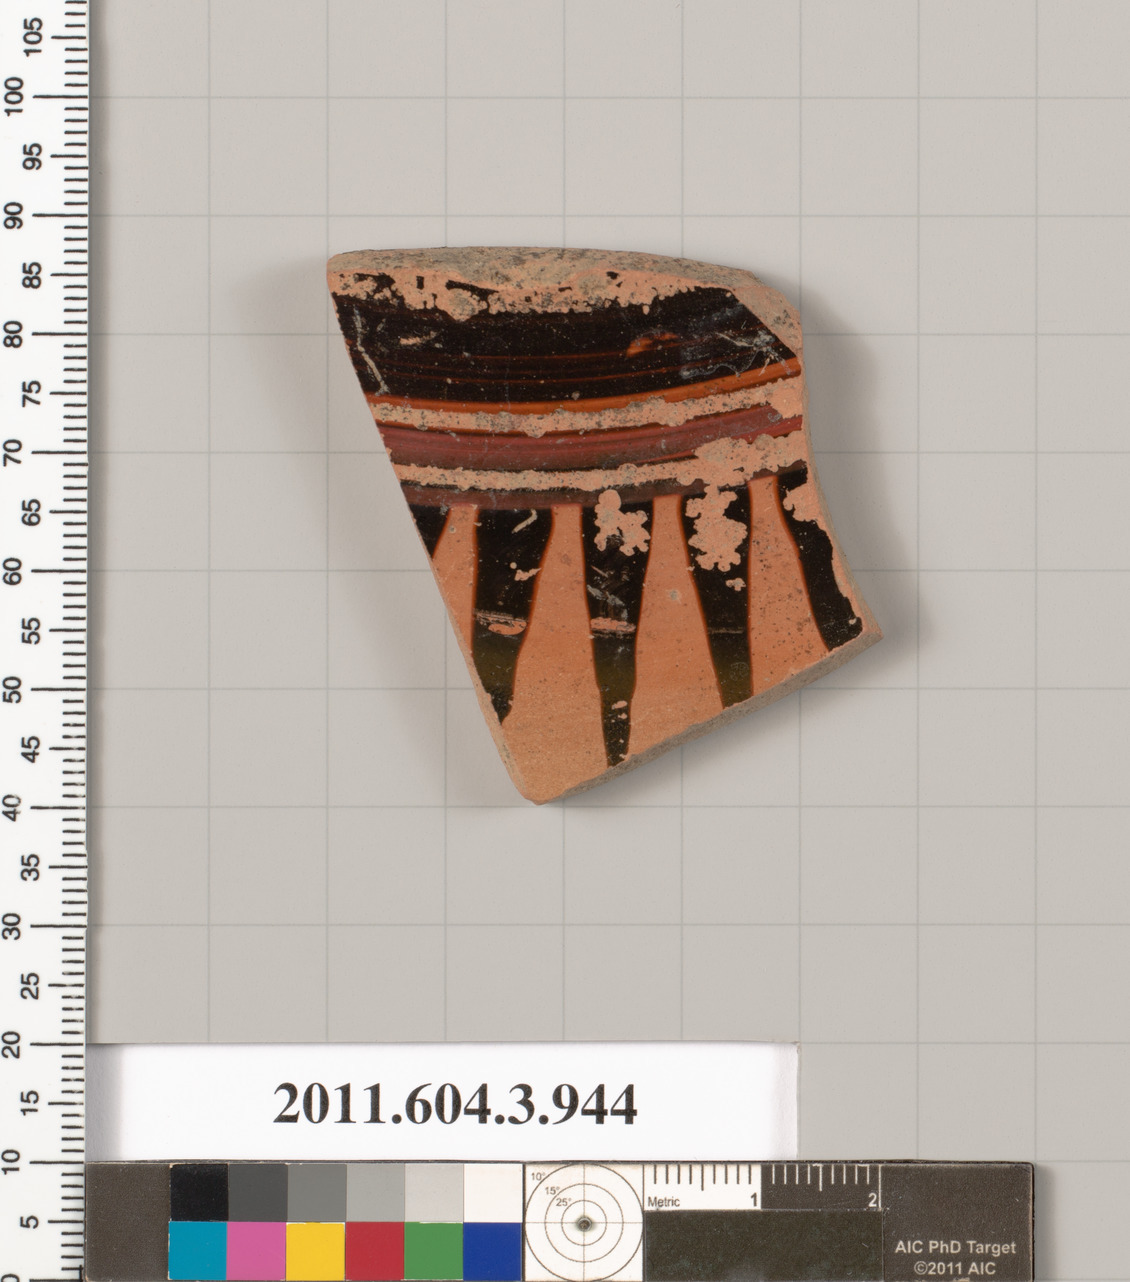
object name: lekanis lid fragment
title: Terracotta fragment of a lekanis lid (covered dish)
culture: greek, attic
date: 600-501 BCE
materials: terracotta